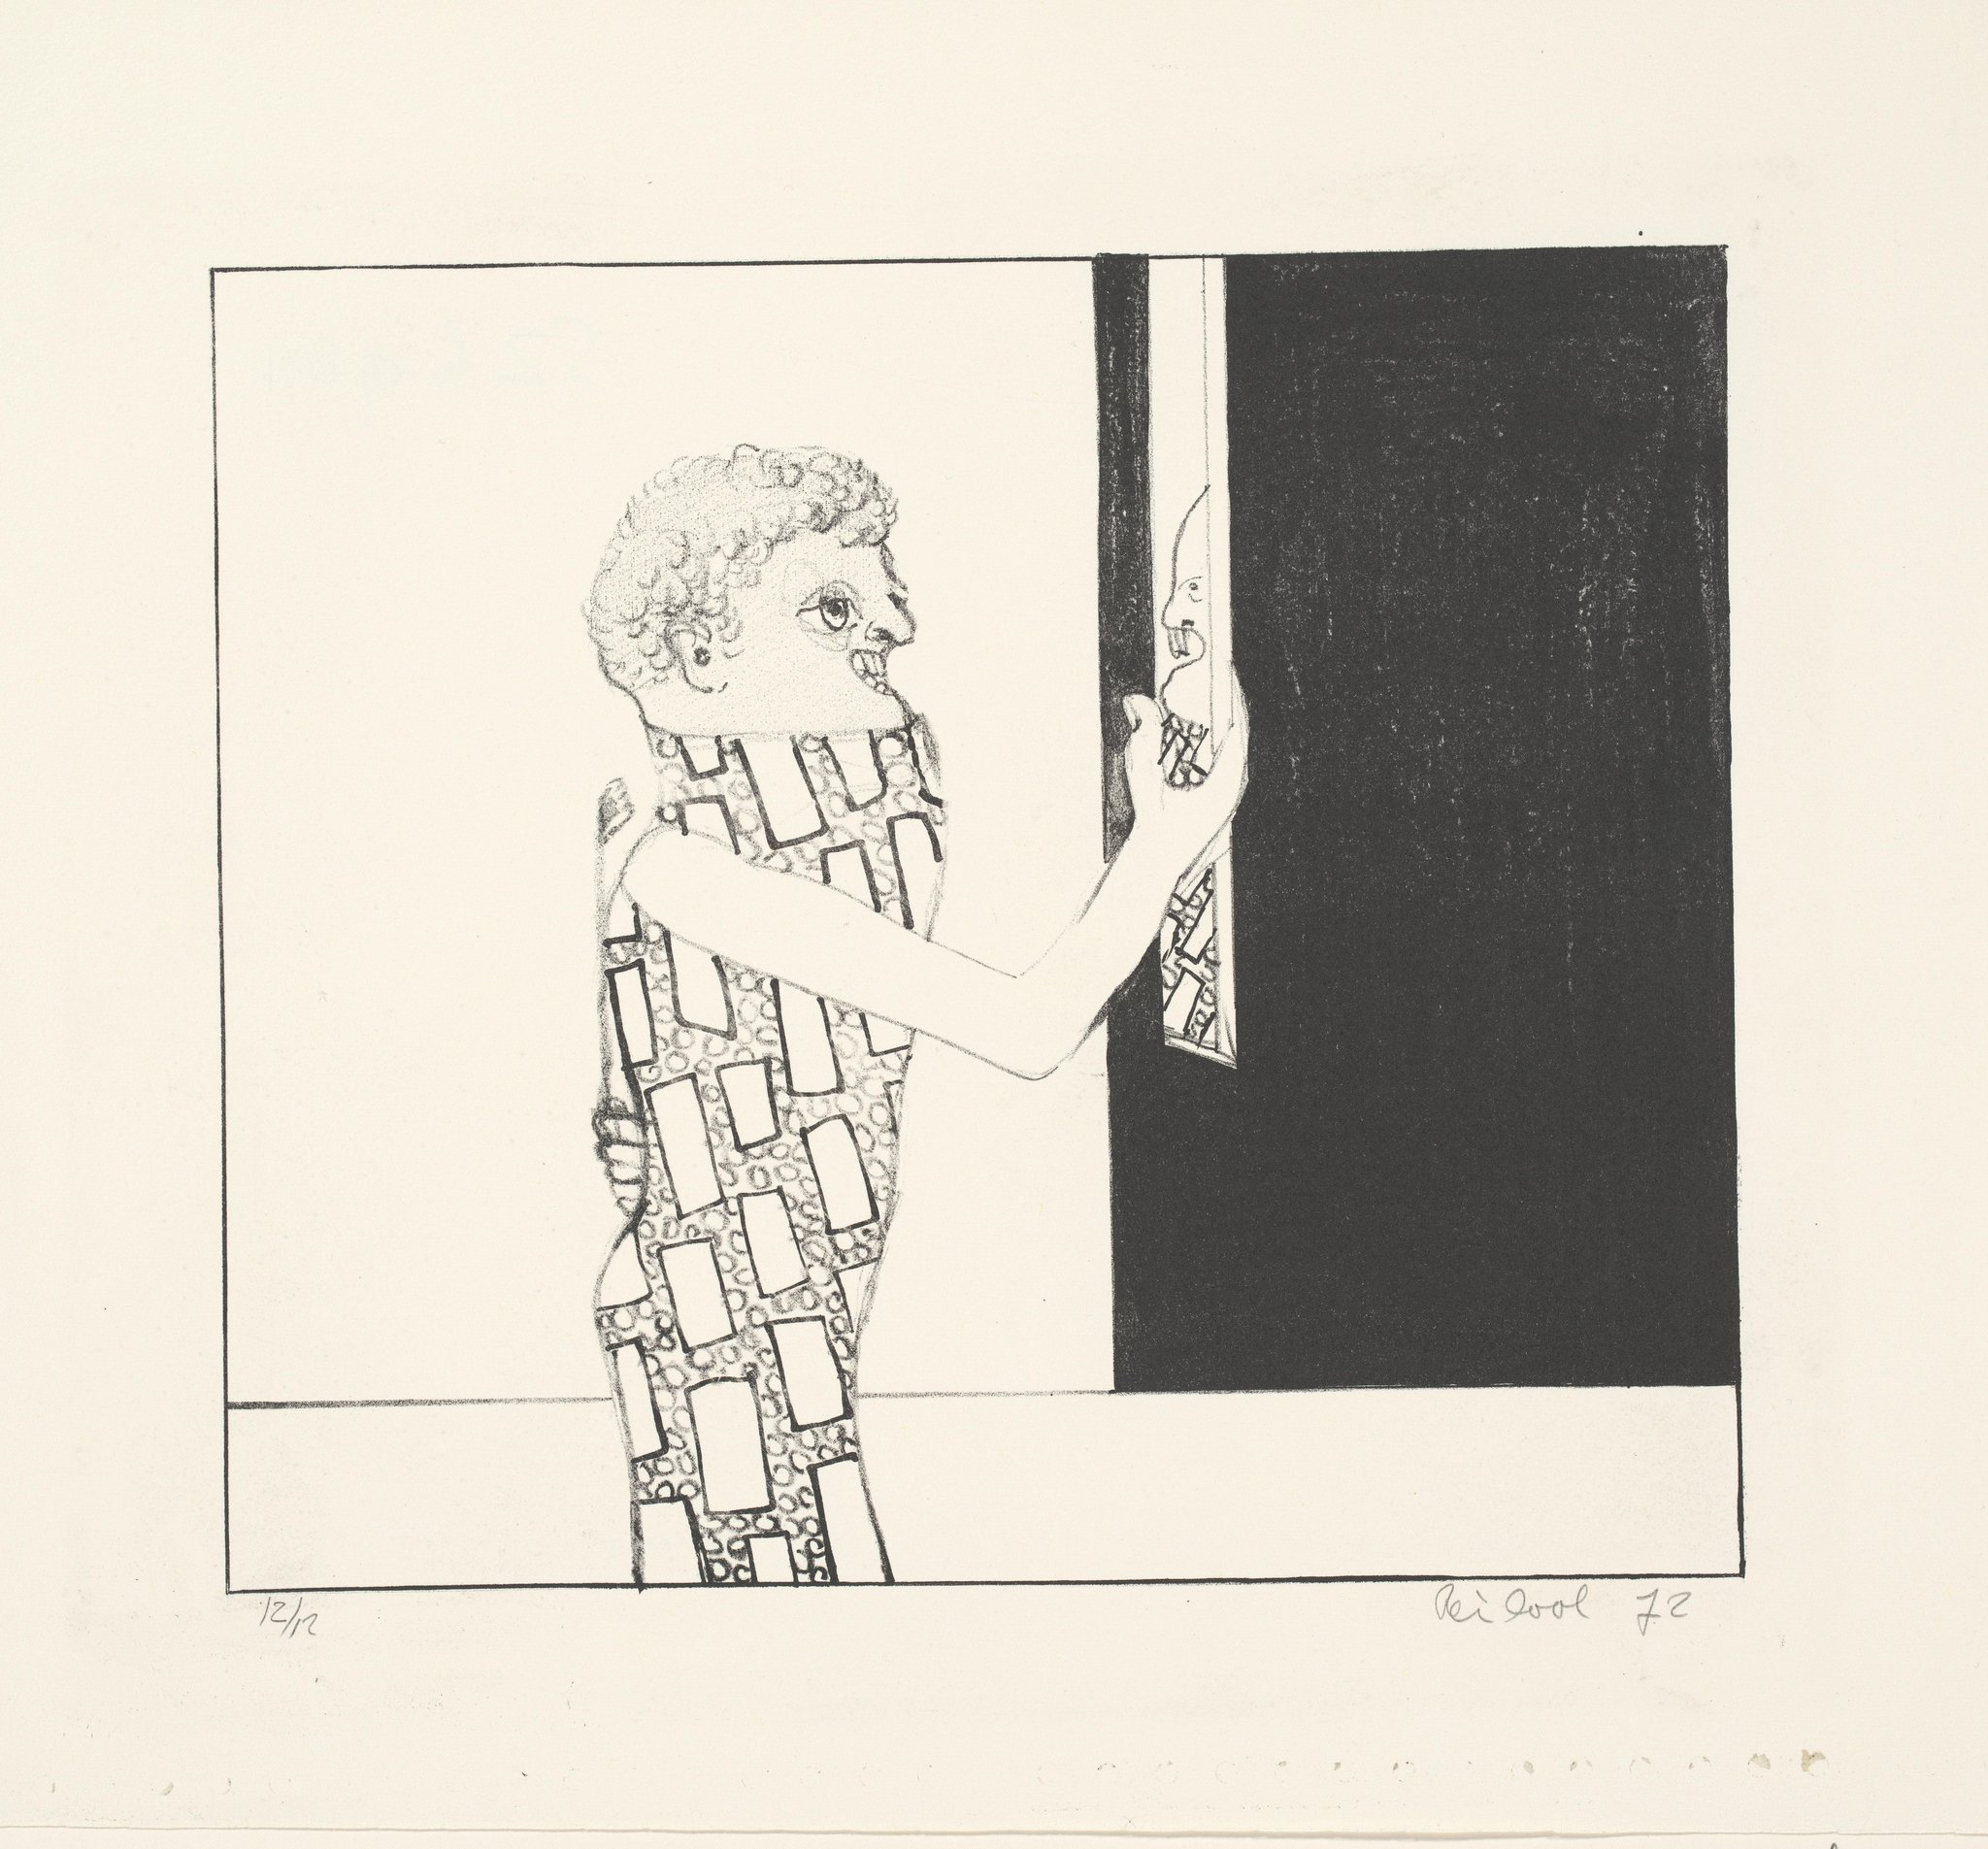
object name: print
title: Vrouw voor spiegel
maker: rein dool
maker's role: draughtsman, painter, print maker, sculptor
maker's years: 1933-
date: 1972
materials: paper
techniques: lithograph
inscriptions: signature and date